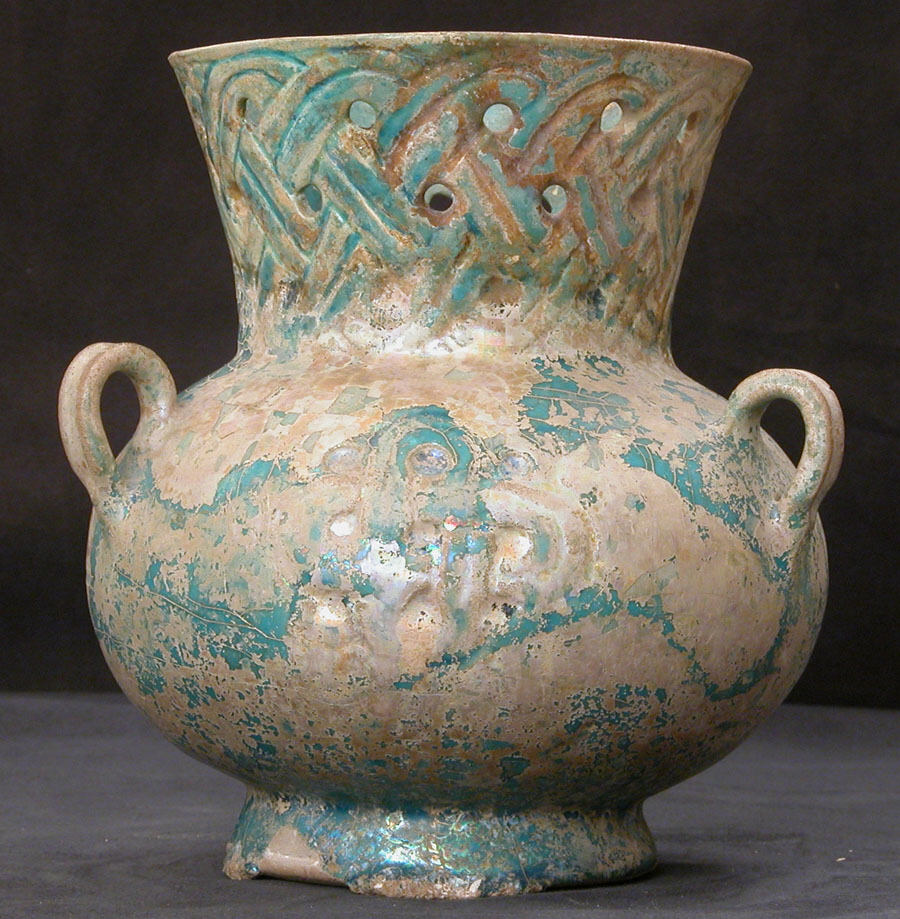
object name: mosque lamp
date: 1101-1200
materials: earthenware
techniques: glazing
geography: syria